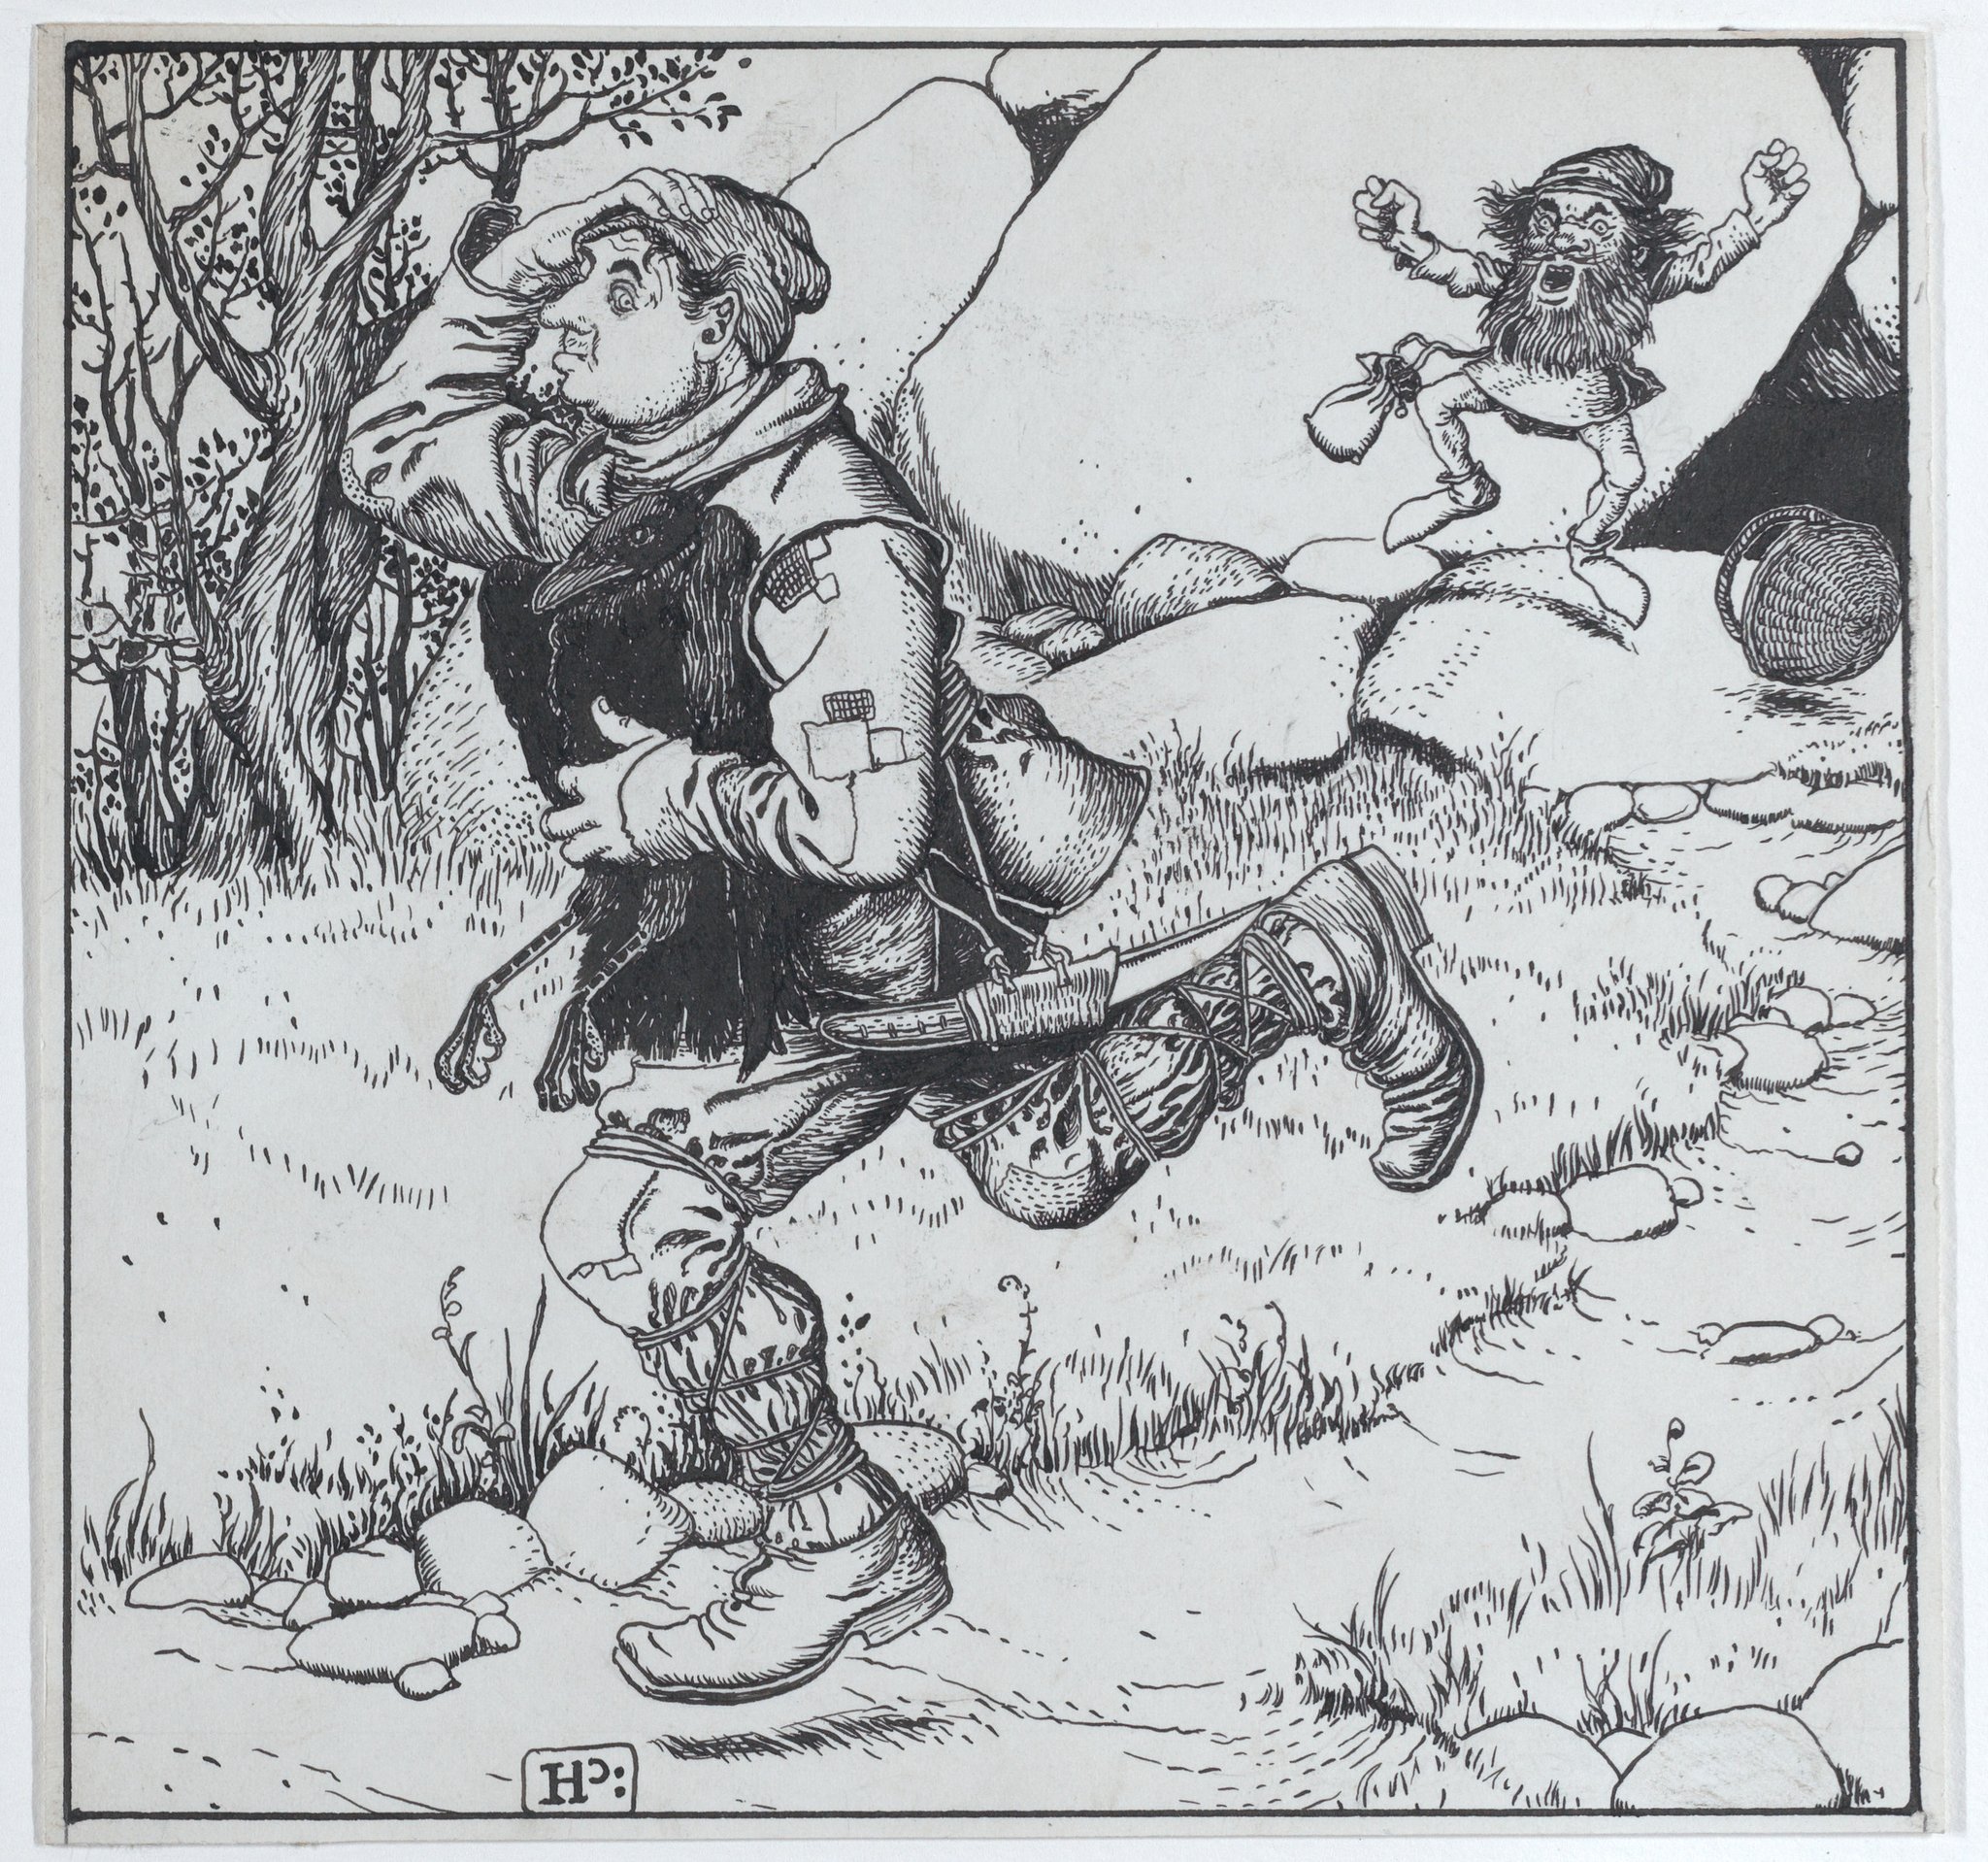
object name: drawing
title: The Blacksmith Chooses Ye Raven and Runs Away With It, for "The Wonder Clock"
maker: howard pyle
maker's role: artist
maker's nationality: american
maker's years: 1853-1911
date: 1887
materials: ink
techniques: pen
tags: birds,men